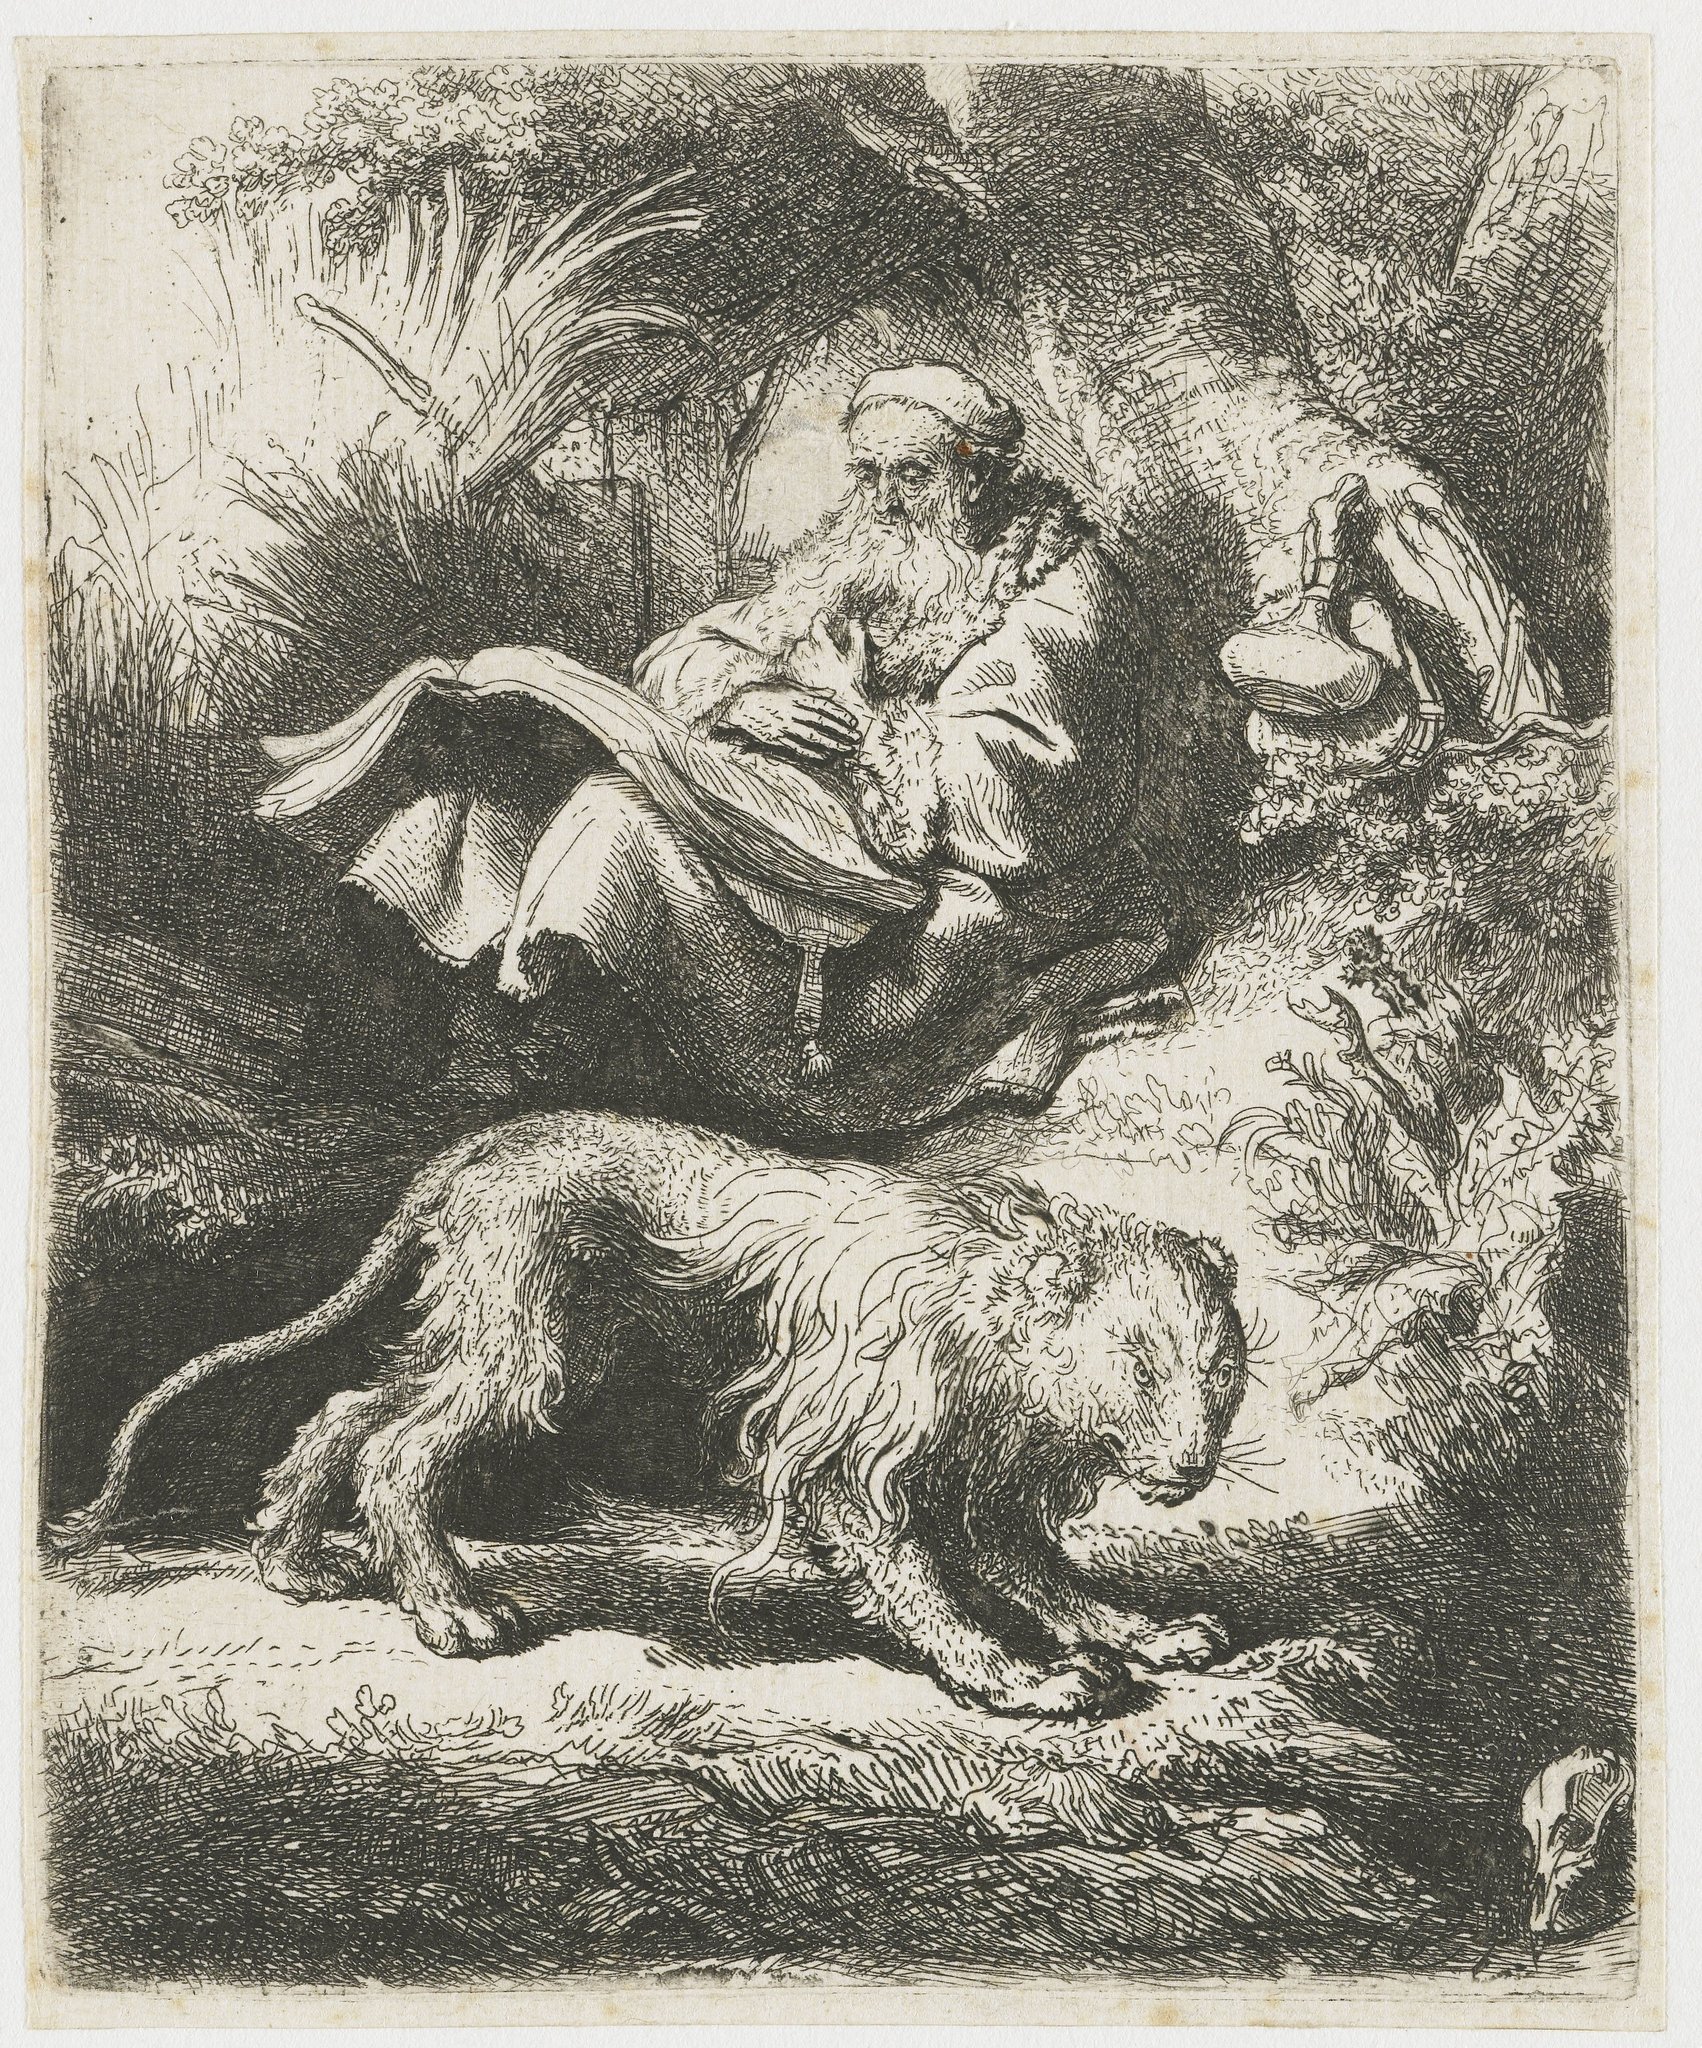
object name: print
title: St Jerome reading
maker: rembrandt van rijn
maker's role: draughtsman, painter, print maker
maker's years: 1606-1669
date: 1634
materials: paper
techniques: etching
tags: st. jerome as hermit in a landscape, reading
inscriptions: date: ‘1634’, signature: ‘Rembrandt f.’, collector's mark: Lugt 240